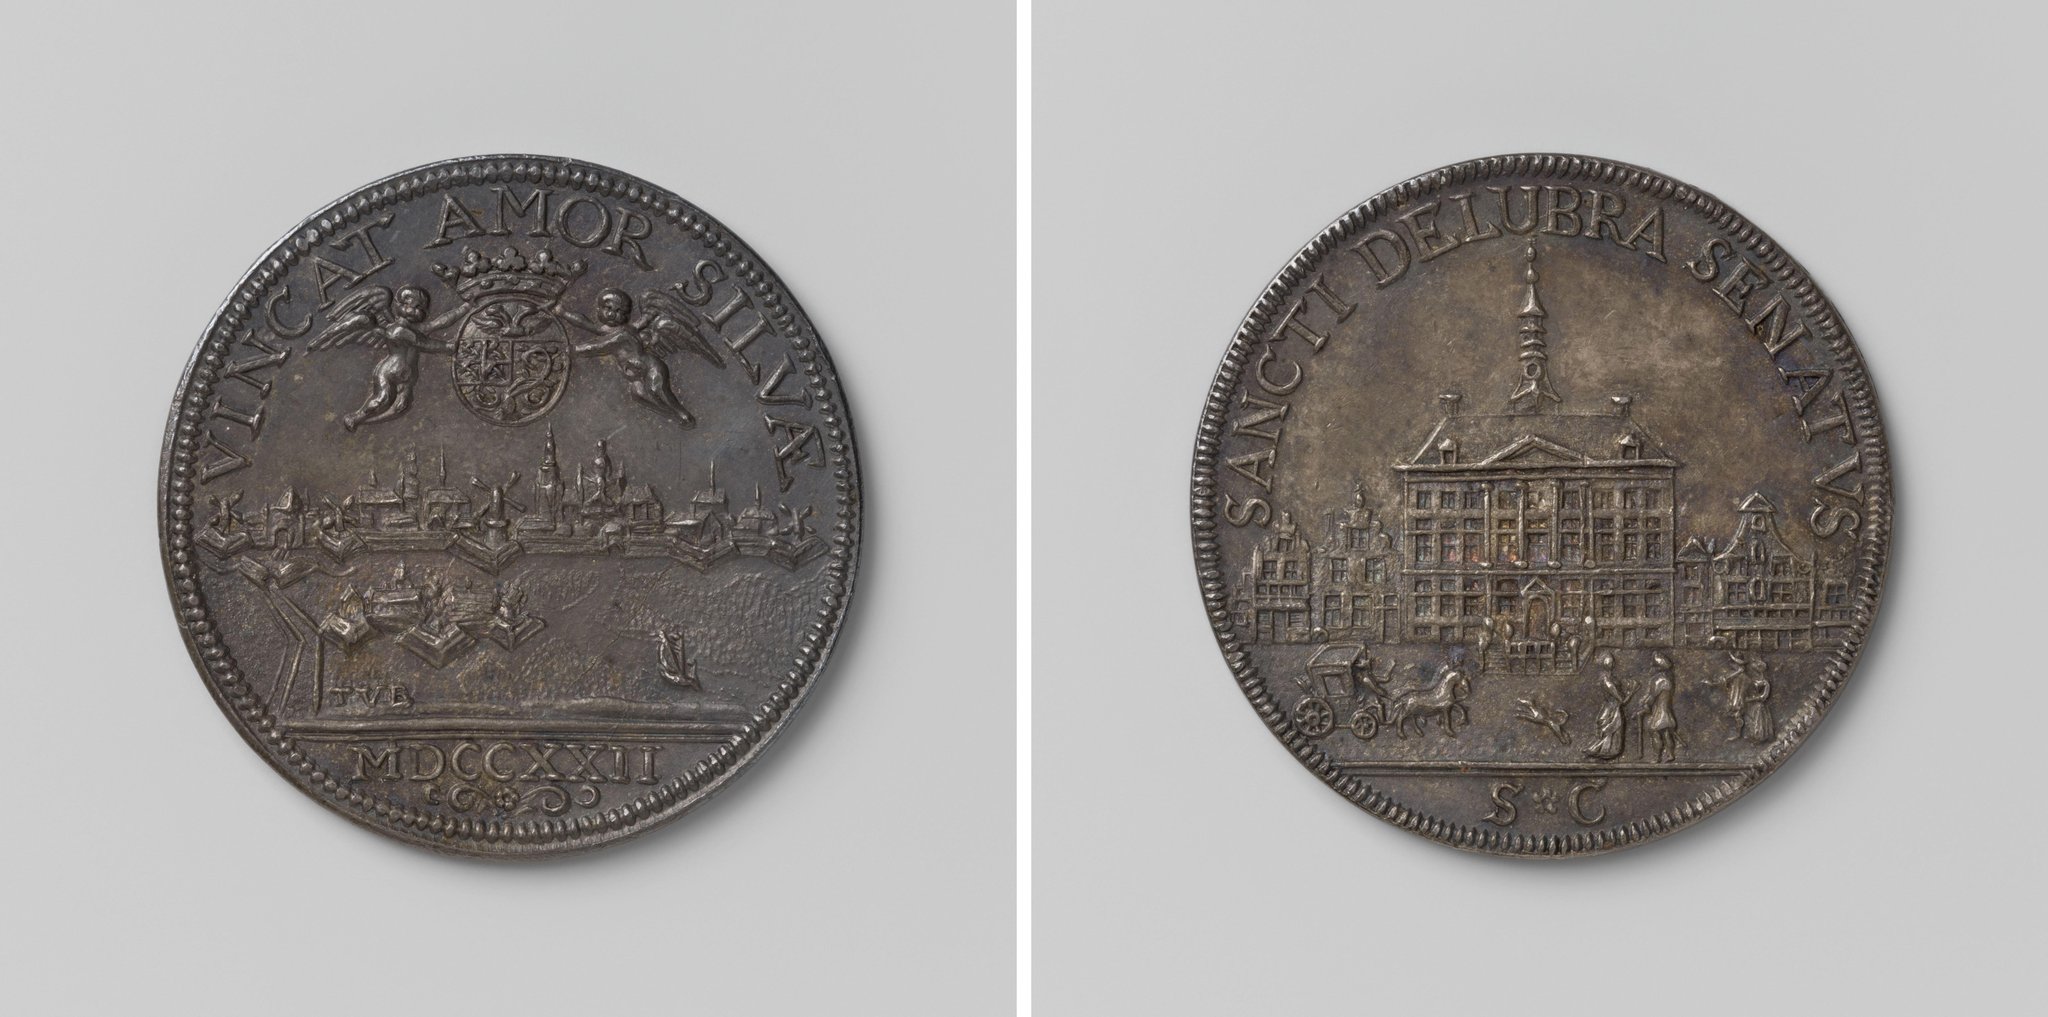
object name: council medal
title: Vroedschapspenning van de stad 's-Hertogenbosch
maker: theodorus casparus van berckel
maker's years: 1680-1734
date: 1722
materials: silver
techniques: striking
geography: den bosch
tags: den bosch